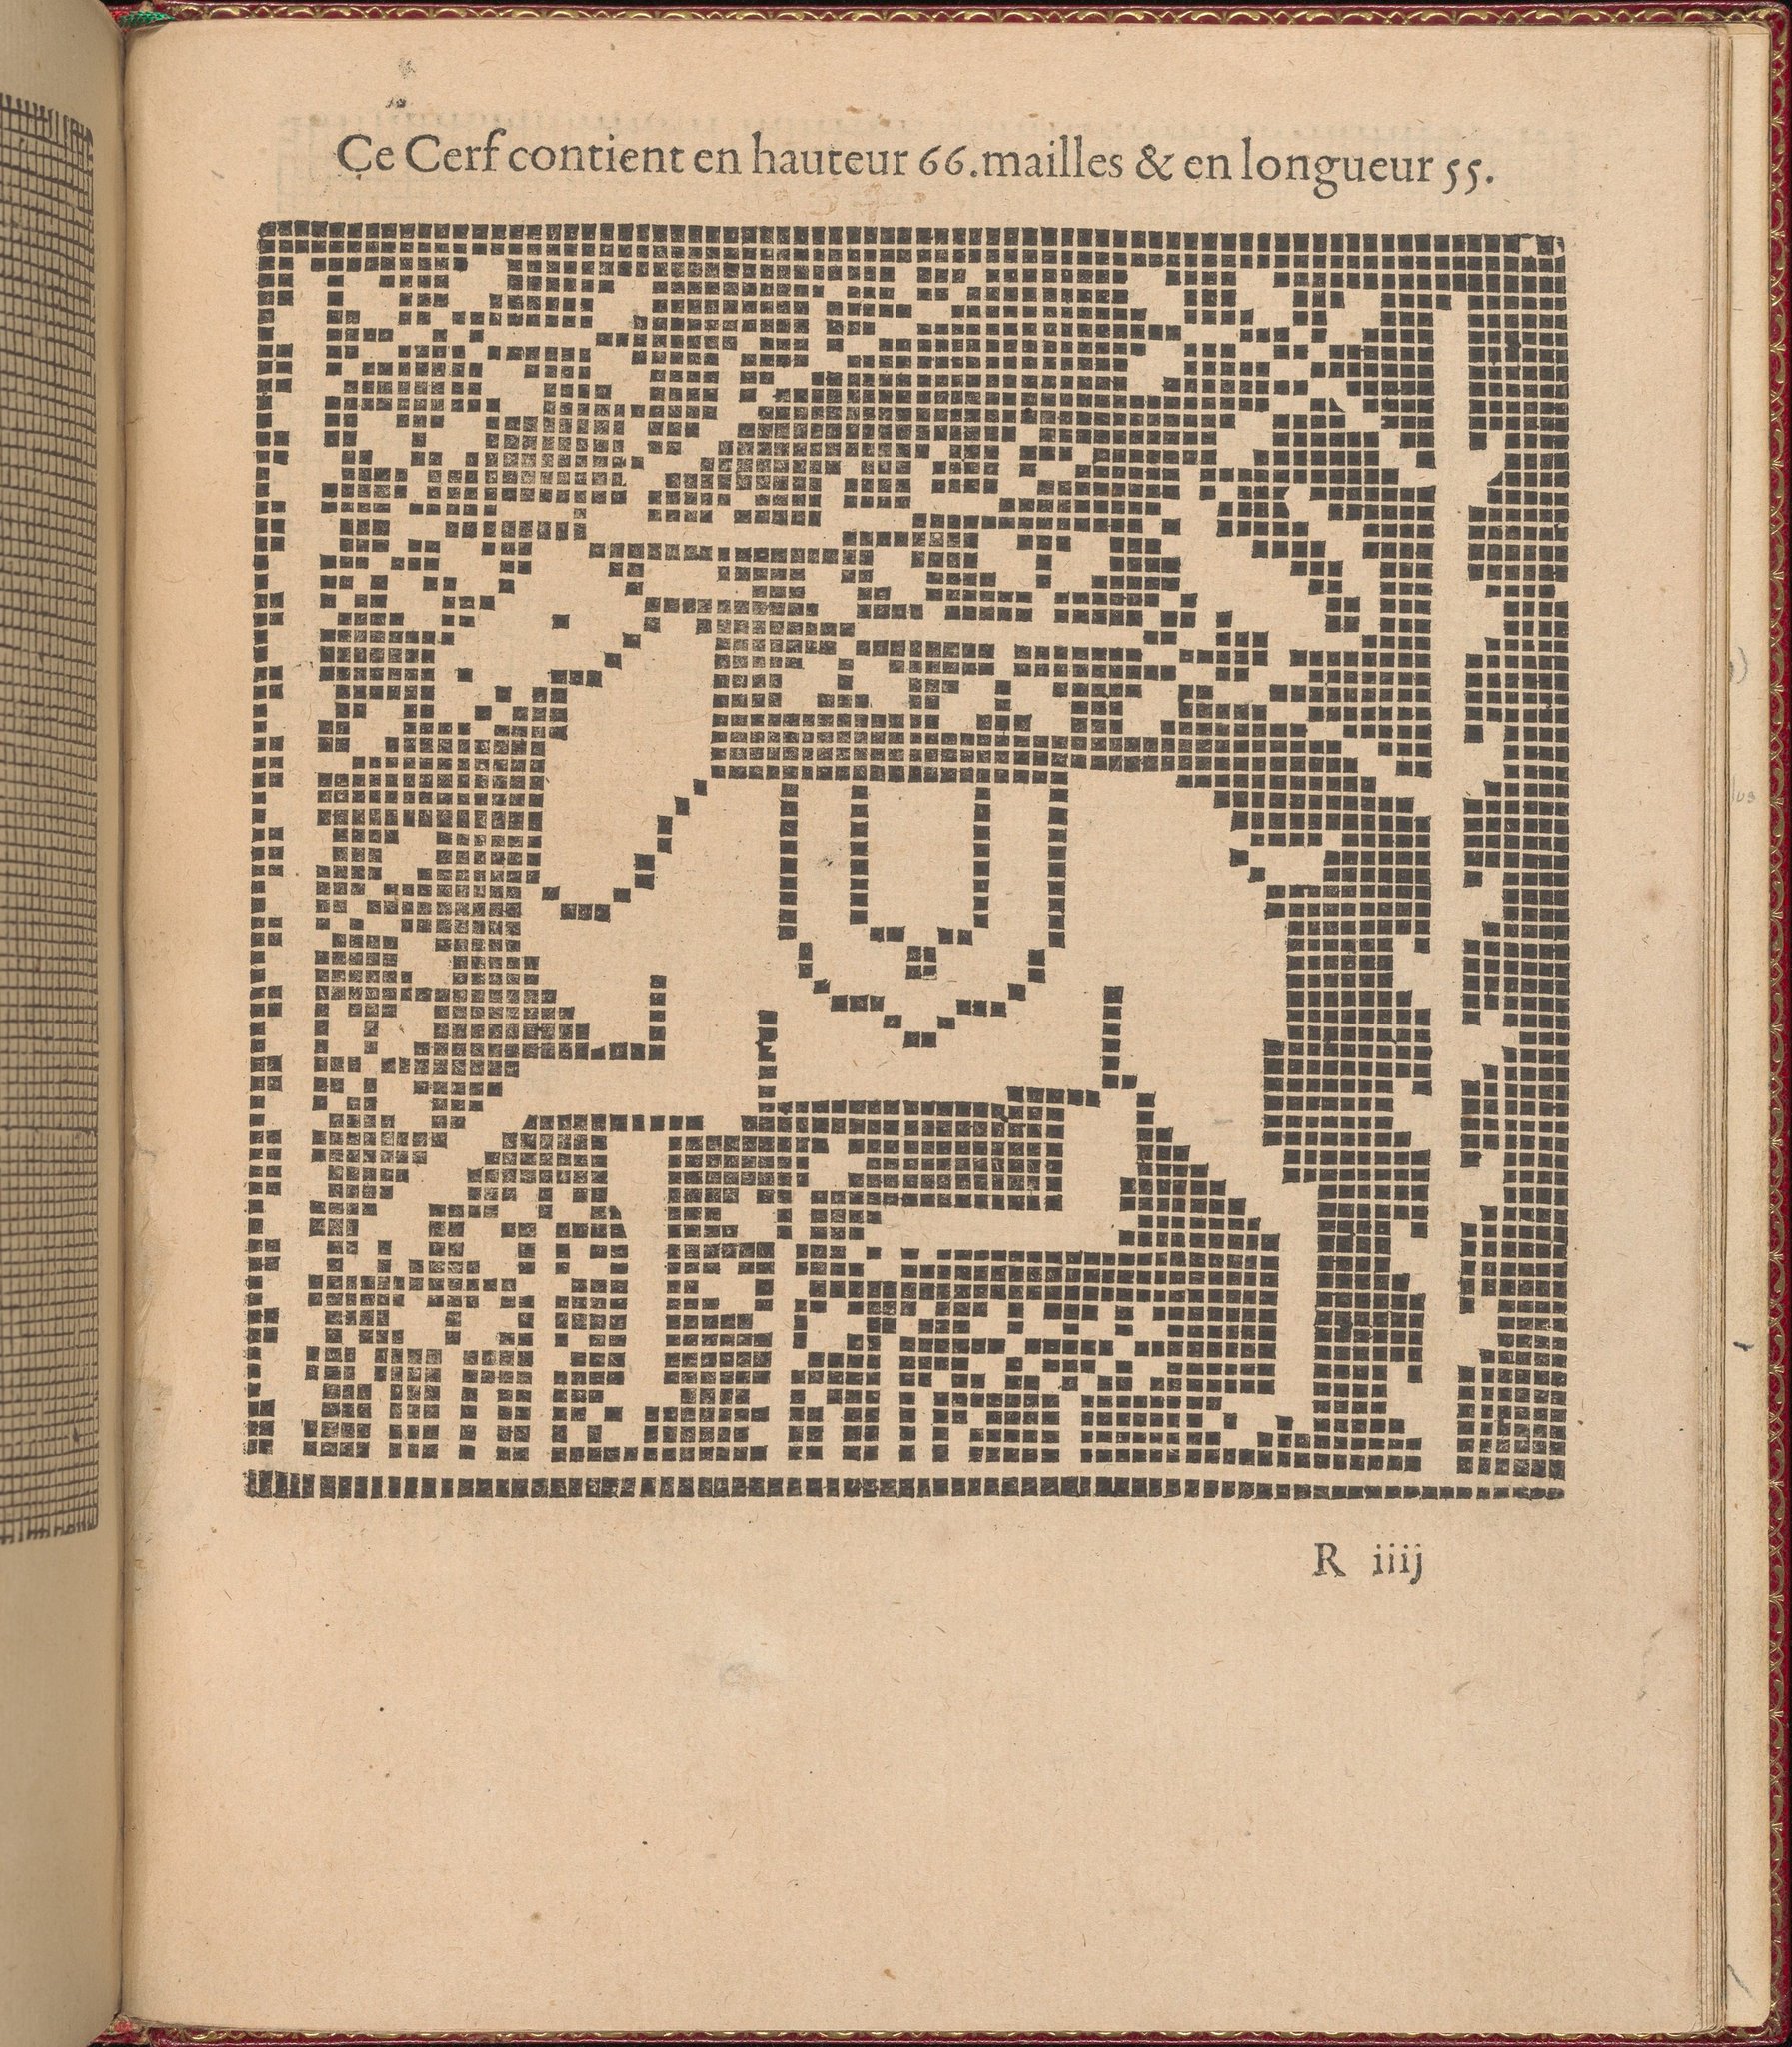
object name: book print ornament architecture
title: Les Singuliers et Nouveaux Portraicts... page 68 (recto)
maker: federico de vinciolo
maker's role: designer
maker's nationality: italian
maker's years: 1582-1599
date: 1588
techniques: woodcut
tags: animals